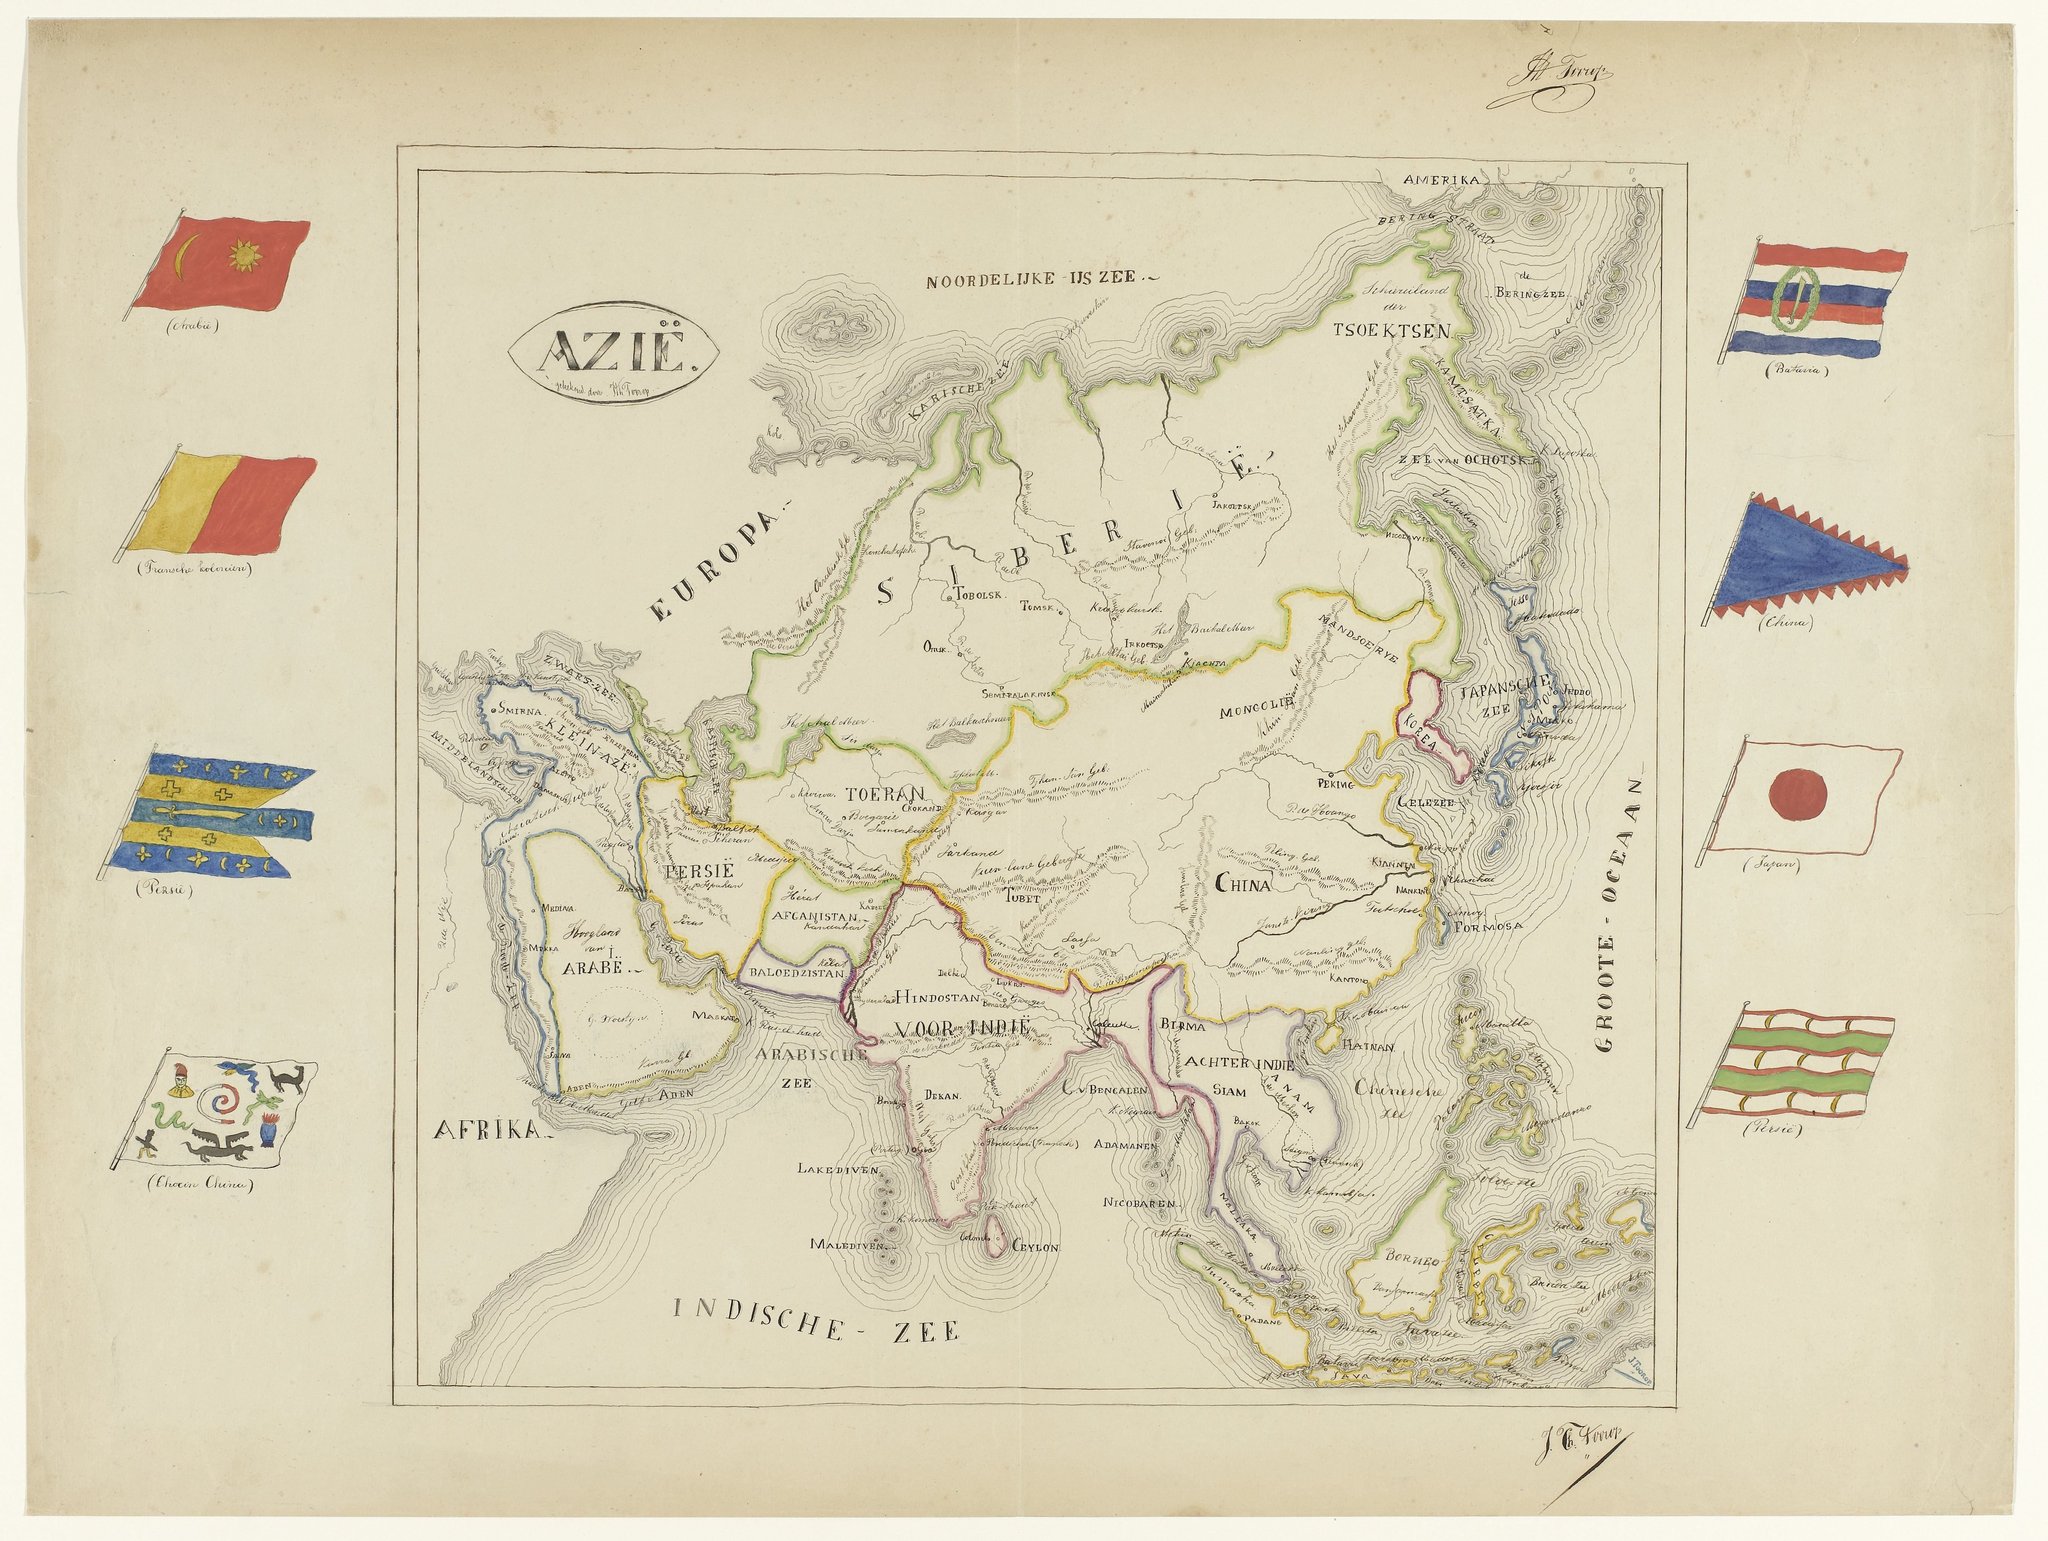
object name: drawing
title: Kaart van Azië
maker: jan toorop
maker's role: draughtsman, painter, print maker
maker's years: 1858-1928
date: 1868-1928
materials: ink, paper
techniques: brush, pen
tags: (map of) asia